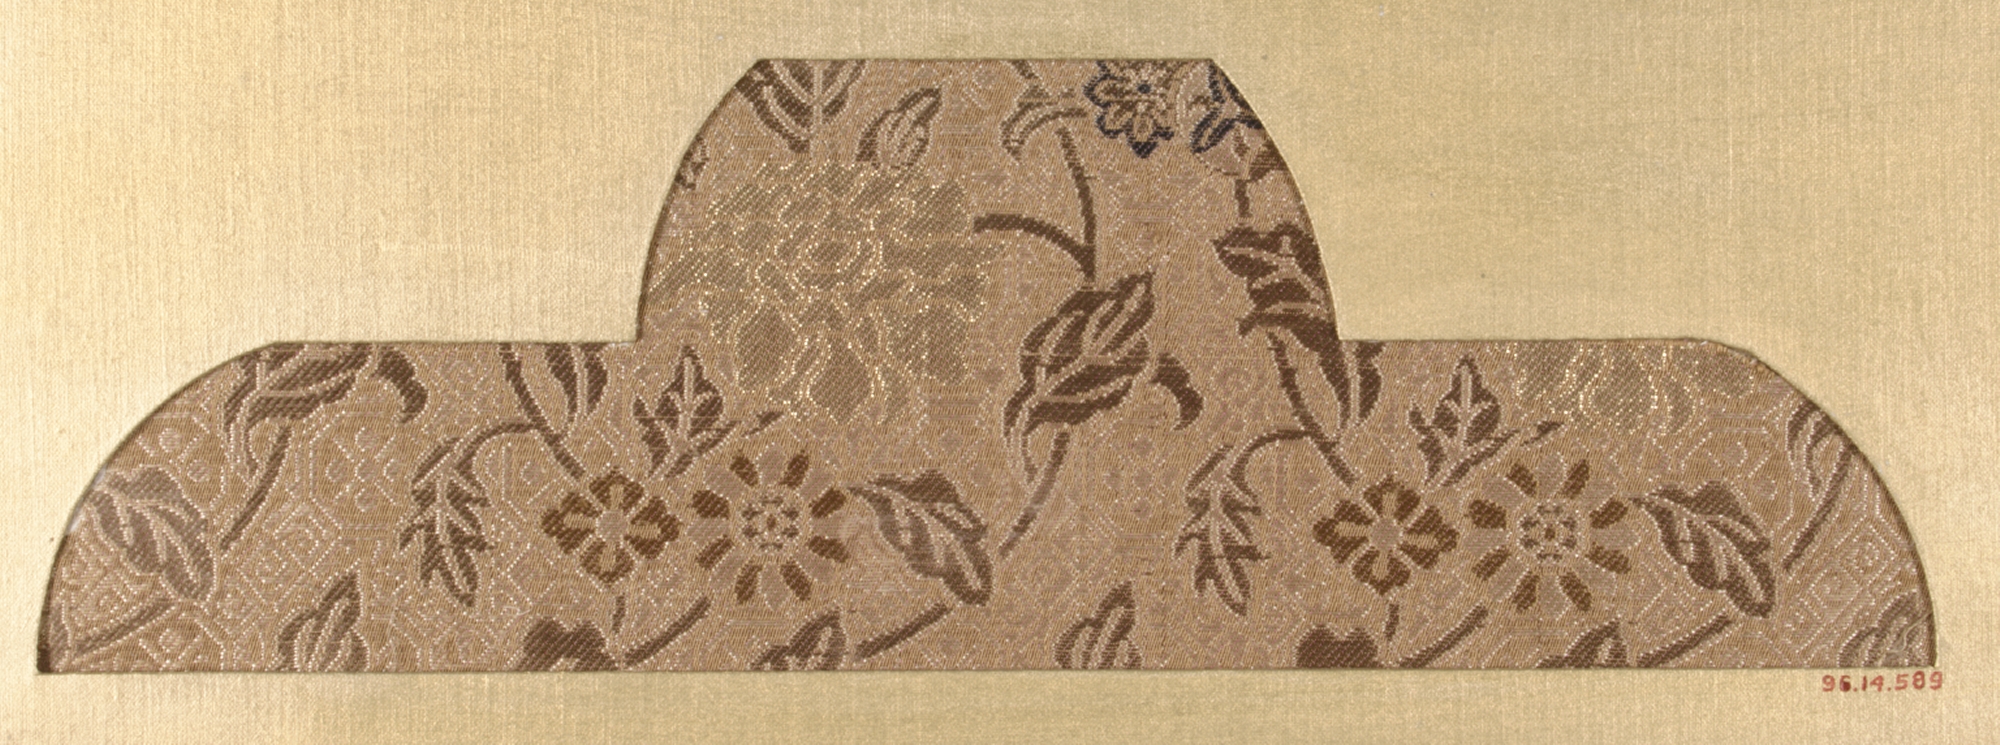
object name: piece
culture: japanese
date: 1701-1900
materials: silk